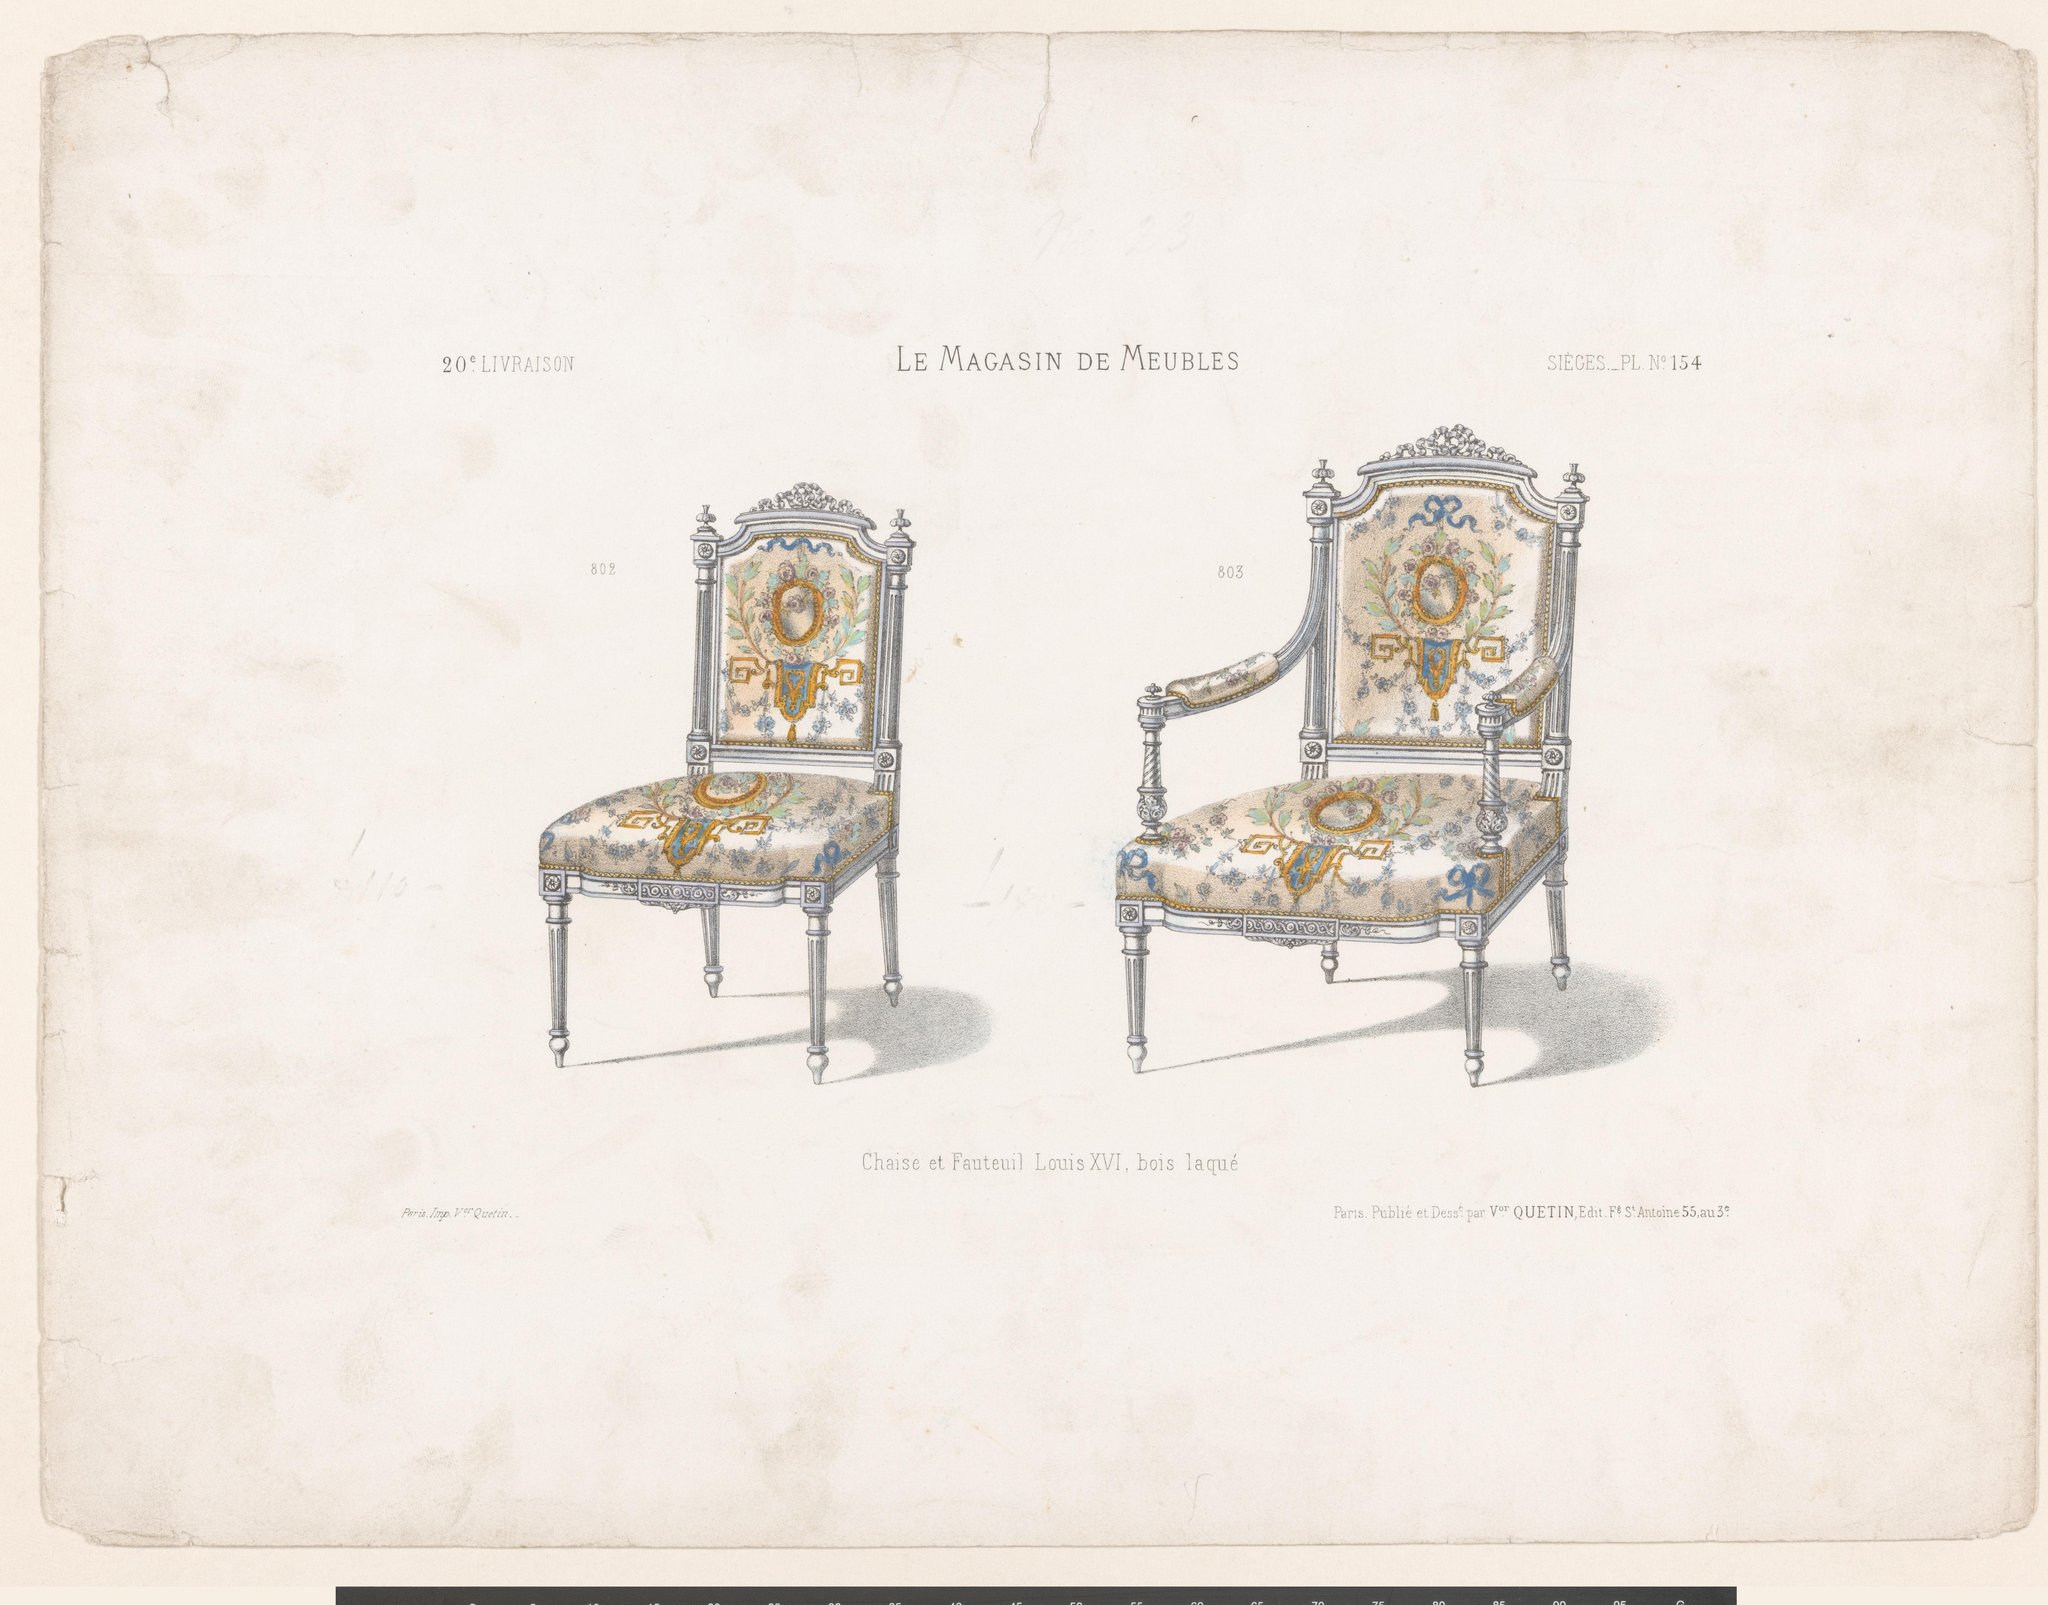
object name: print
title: Le Magasin de Meubles / Sièges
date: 1832-1877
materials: paper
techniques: hand coloring, lithograph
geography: paris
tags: seating furniture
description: Een stoel en fauteuil in de Lodewijk XVI-stijl. Prent uit 20e Livraison.